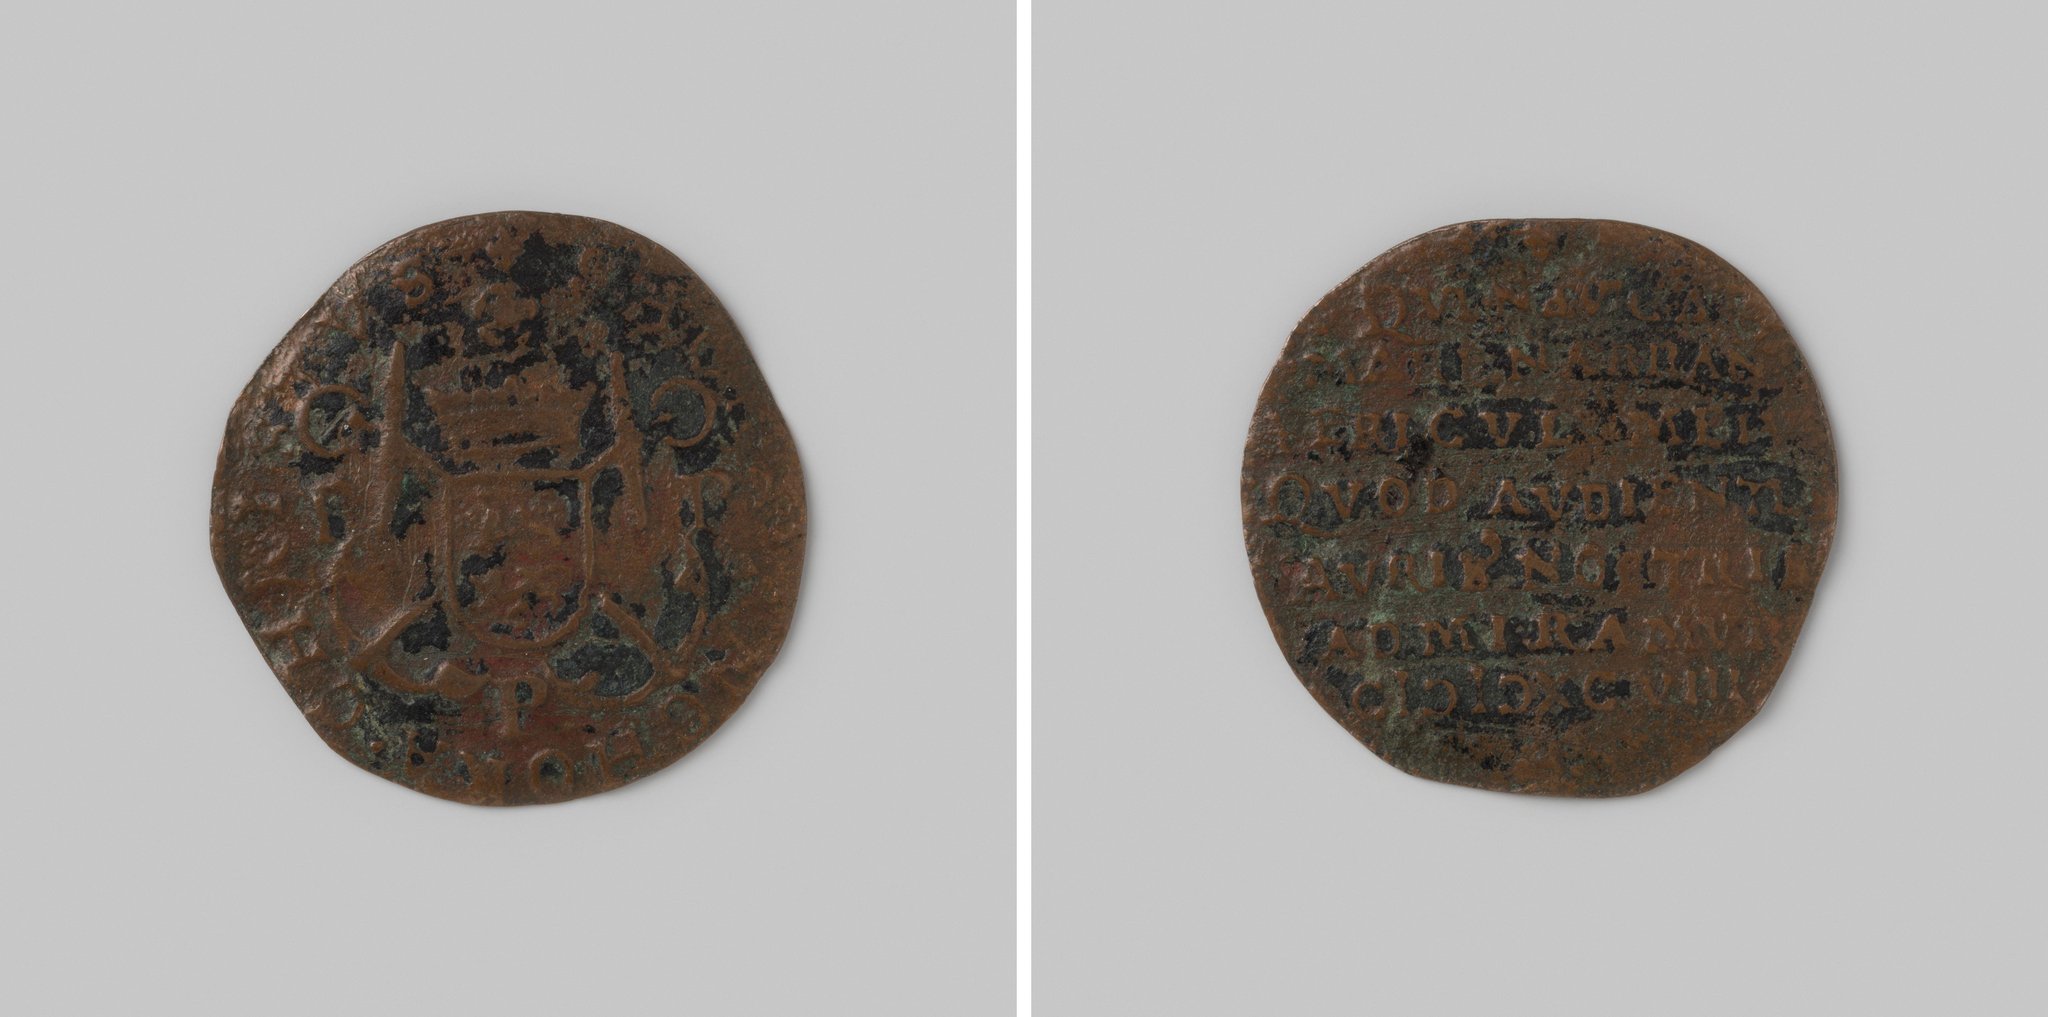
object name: history medal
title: Rekenpenning op de terugkeer van de Nederlandse schepen uit Oost-Indië 1598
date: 1598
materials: copper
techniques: striking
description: Koperen penning, op de voorzijde het gekroonde wapenschild van West Friesland op gekruiste ankers, met omschrift, op de keerzijde zeven regels tekst.